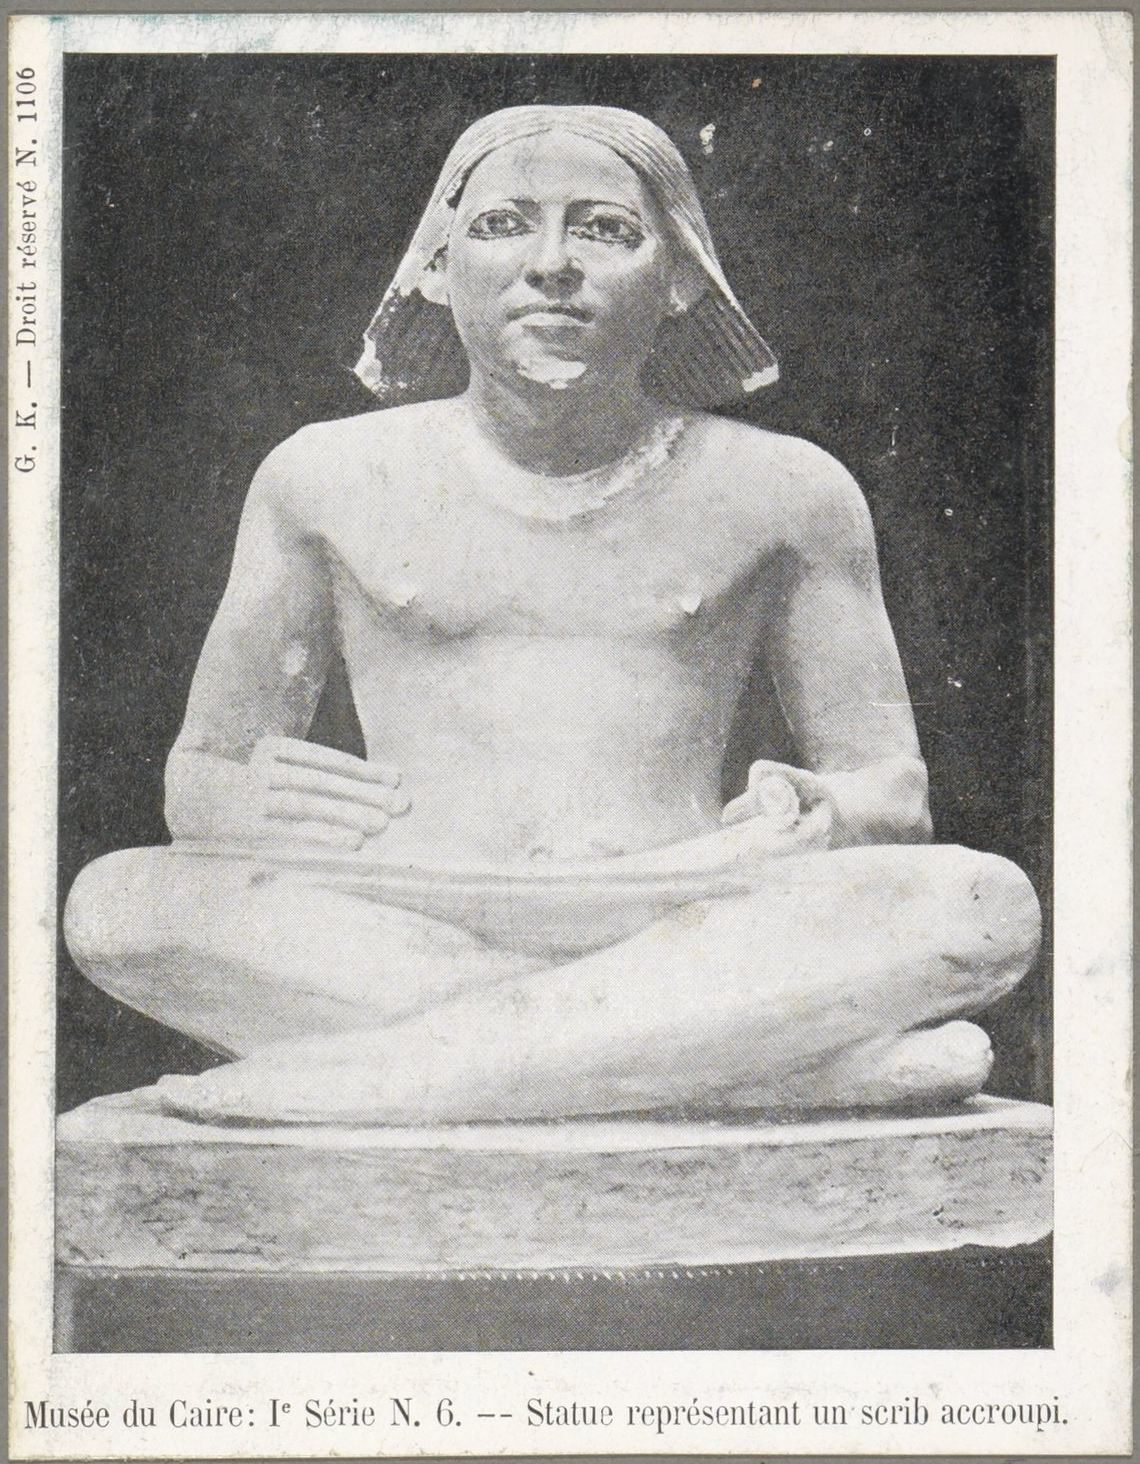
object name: photograph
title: Beeld van een zittende schrijver in het museum van Caïro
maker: gk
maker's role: fotograaf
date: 1895-1905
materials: paper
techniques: autotype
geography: cairo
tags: monument, statue, permanent exhibition, museum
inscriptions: inscription: ‘G.K. - Droit réservé N. 1106’, number: ‘Ie Série N. 6’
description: Onderdeel van Reisalbum met foto's van bezienswaardigheden in Griekenland en Egypte.